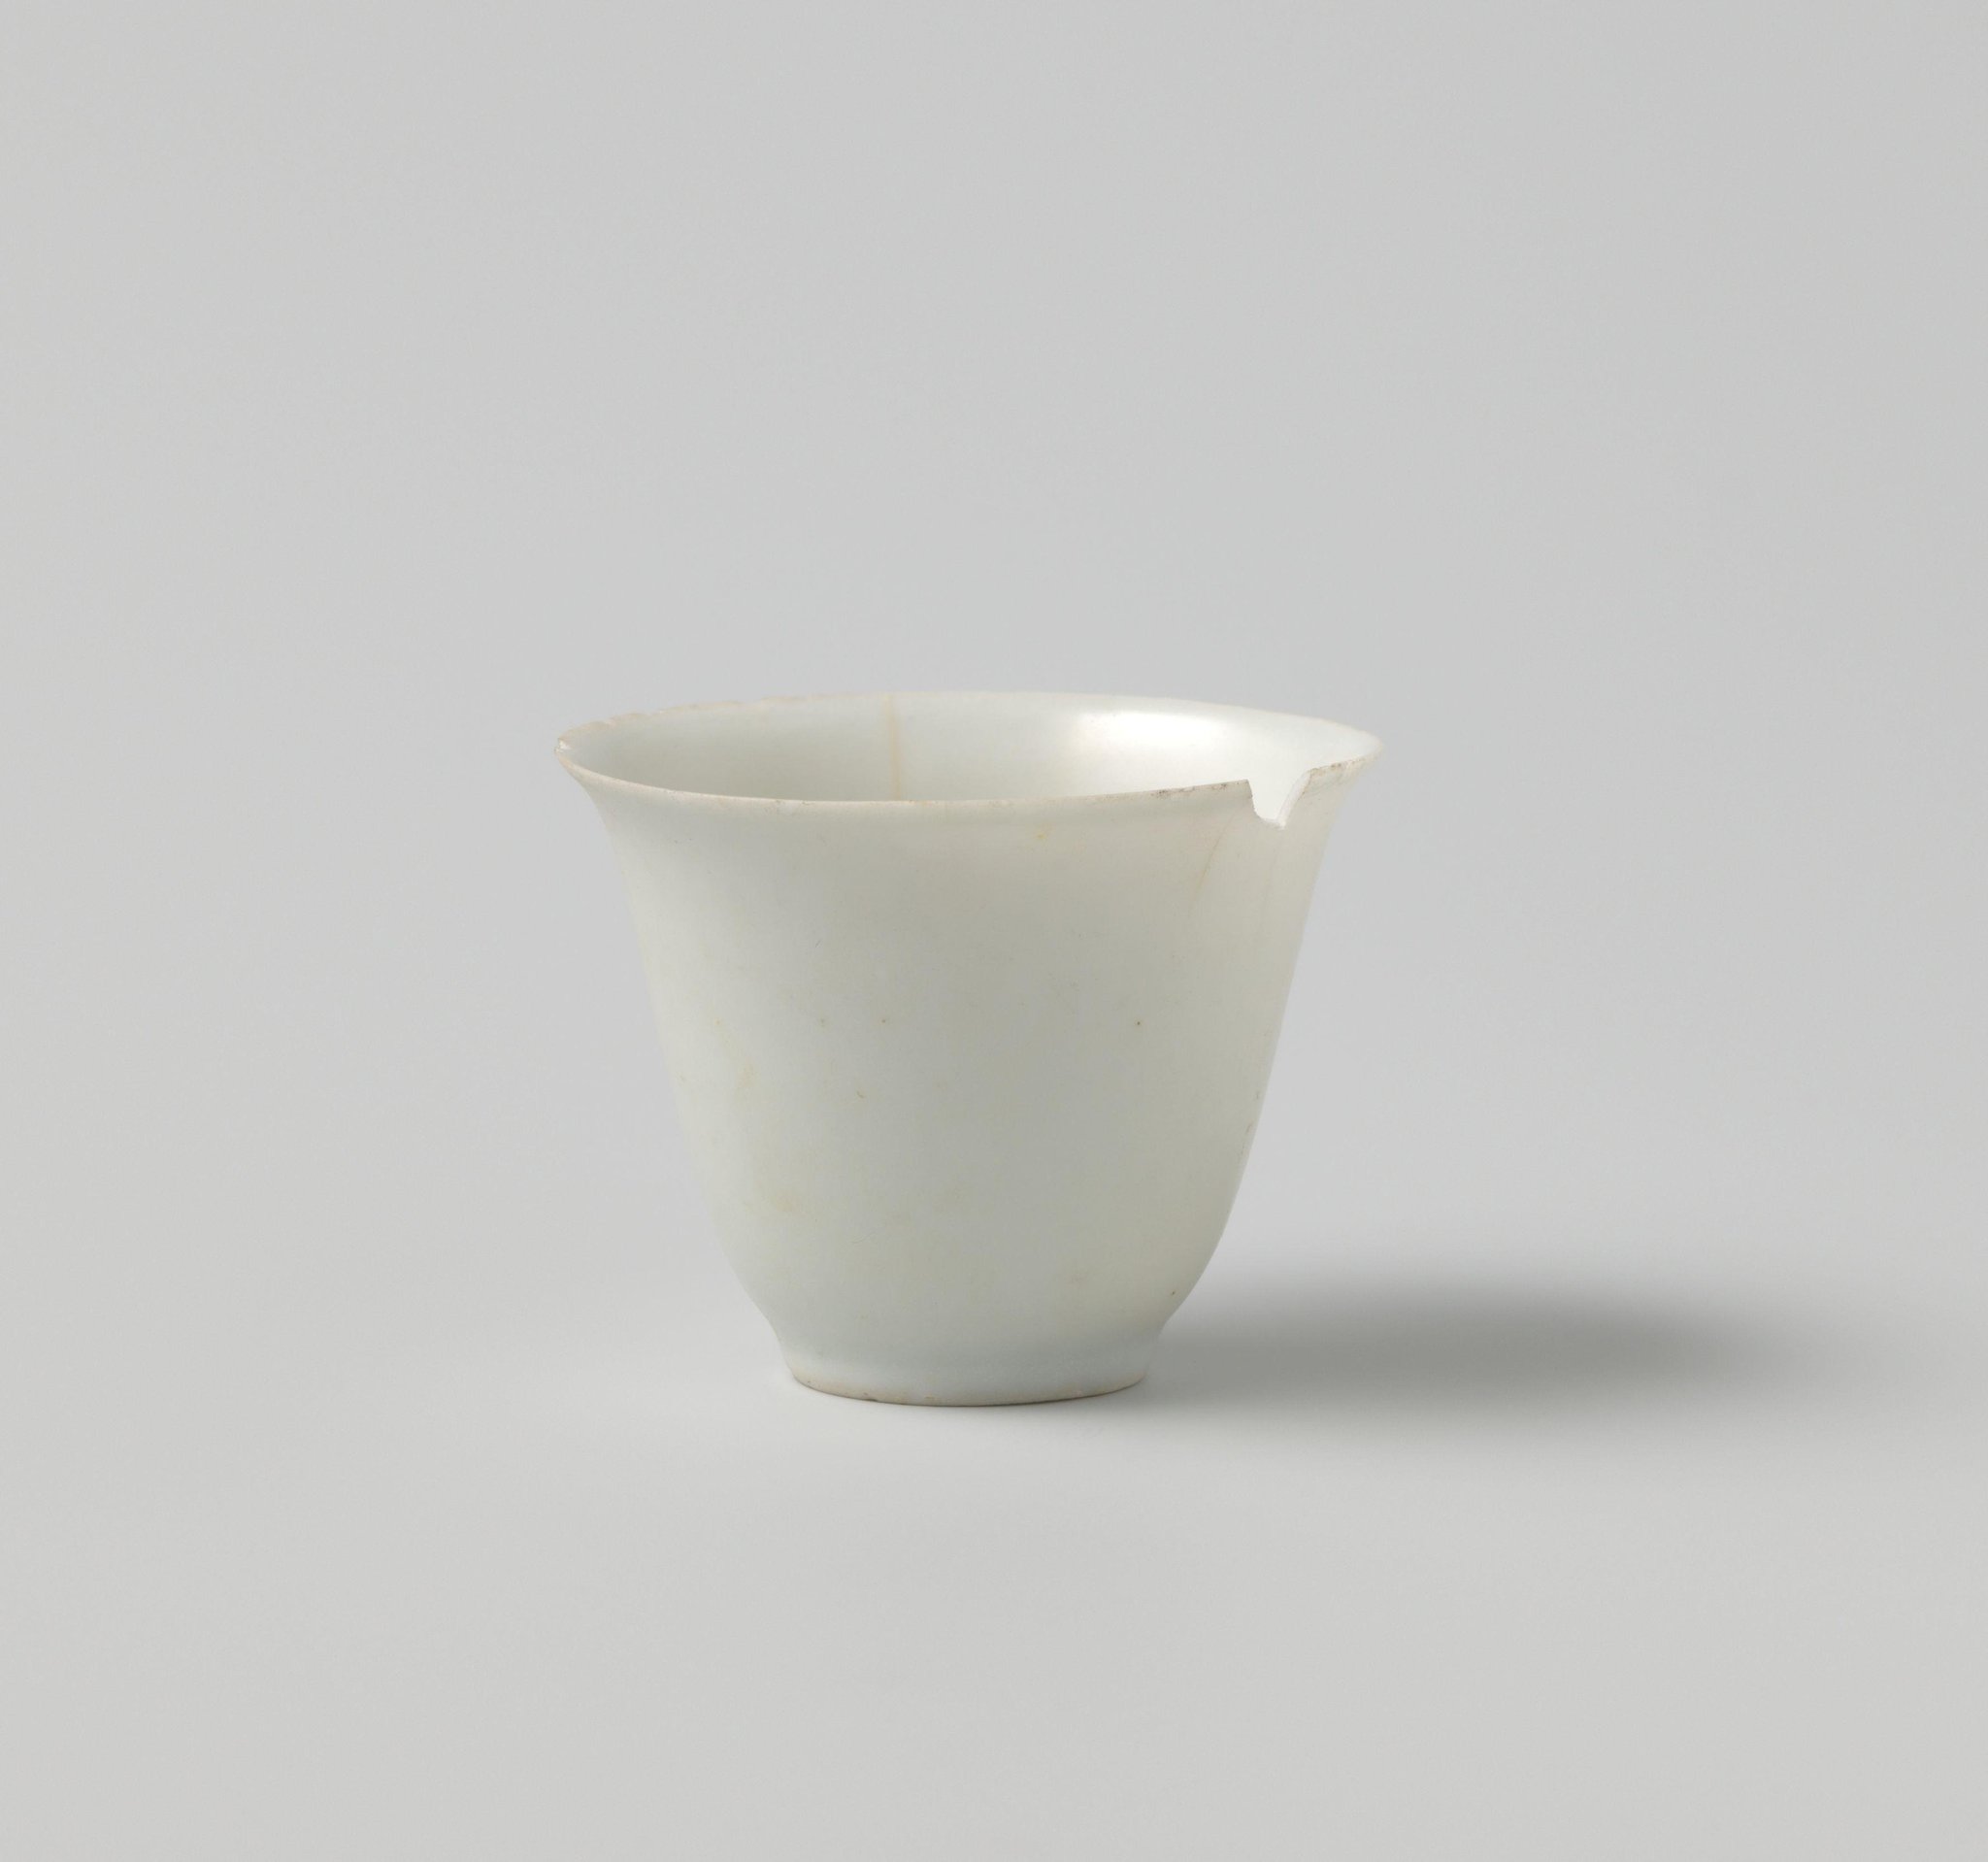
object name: cup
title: Wijnkop uit V.O.C.-schip de 'Witte Leeuw'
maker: Anonymous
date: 1613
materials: porcelain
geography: jingdezhen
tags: verenigde oostindische compagnie, sint-helena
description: Wijnkop uit V.O.C.-schip de 'Witte Leeuw', 99% bewaard: aan de rand ontbreken enige scherven. De scherf is glasachtig en wit en er is geen ingebakken vuil. De bodem is geglazuurd en de voetring is recht, staat naar binnen en is gefacetteerd. De kom is ongedecoreerd.